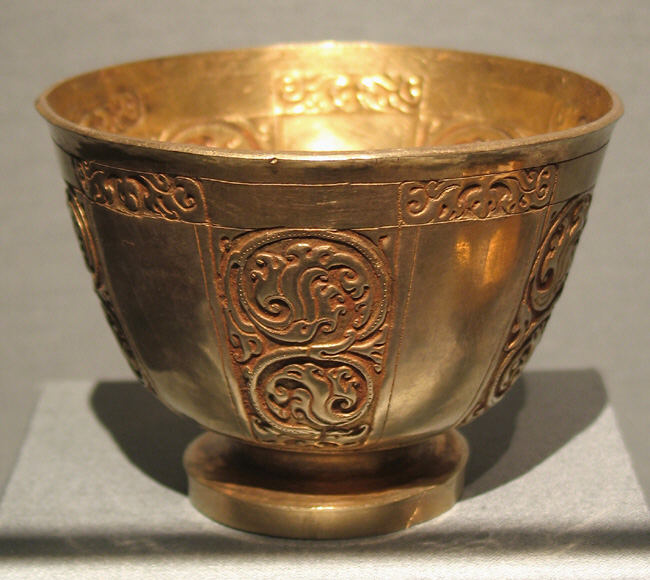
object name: cup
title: Cup with Foliate Panels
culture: indonesian, javanese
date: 701-833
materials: gold